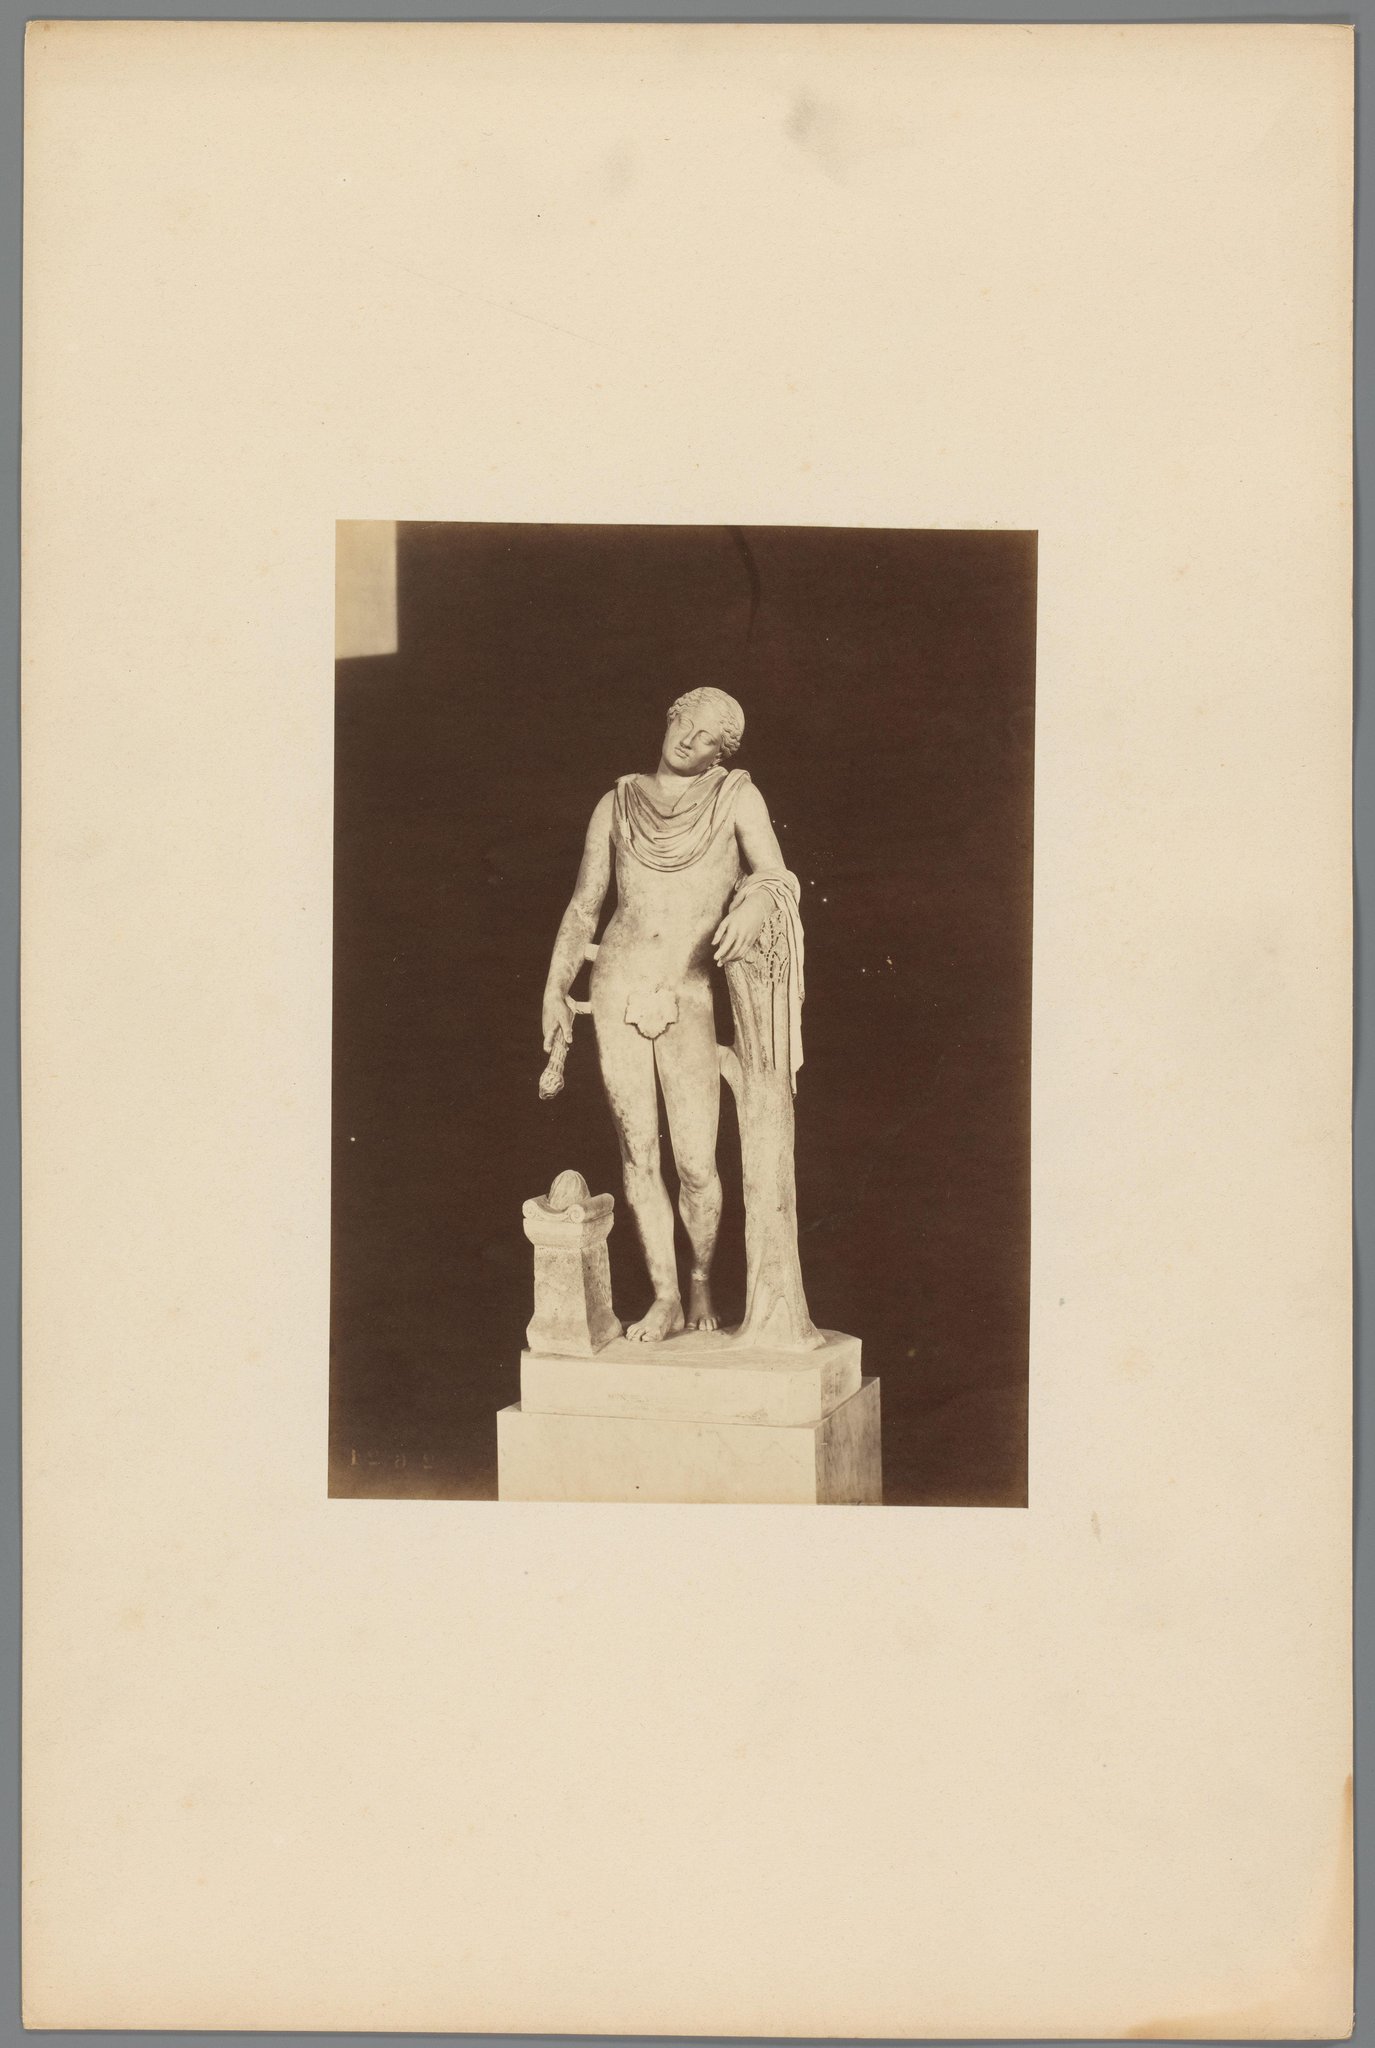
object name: photograph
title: Sculptuur van een figuur met takken in de hand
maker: Anonymous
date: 1851-1900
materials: cardboard, paper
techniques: albumen print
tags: piece of sculpture, reproduction of a piece of sculpture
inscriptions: number: ‘[...]’